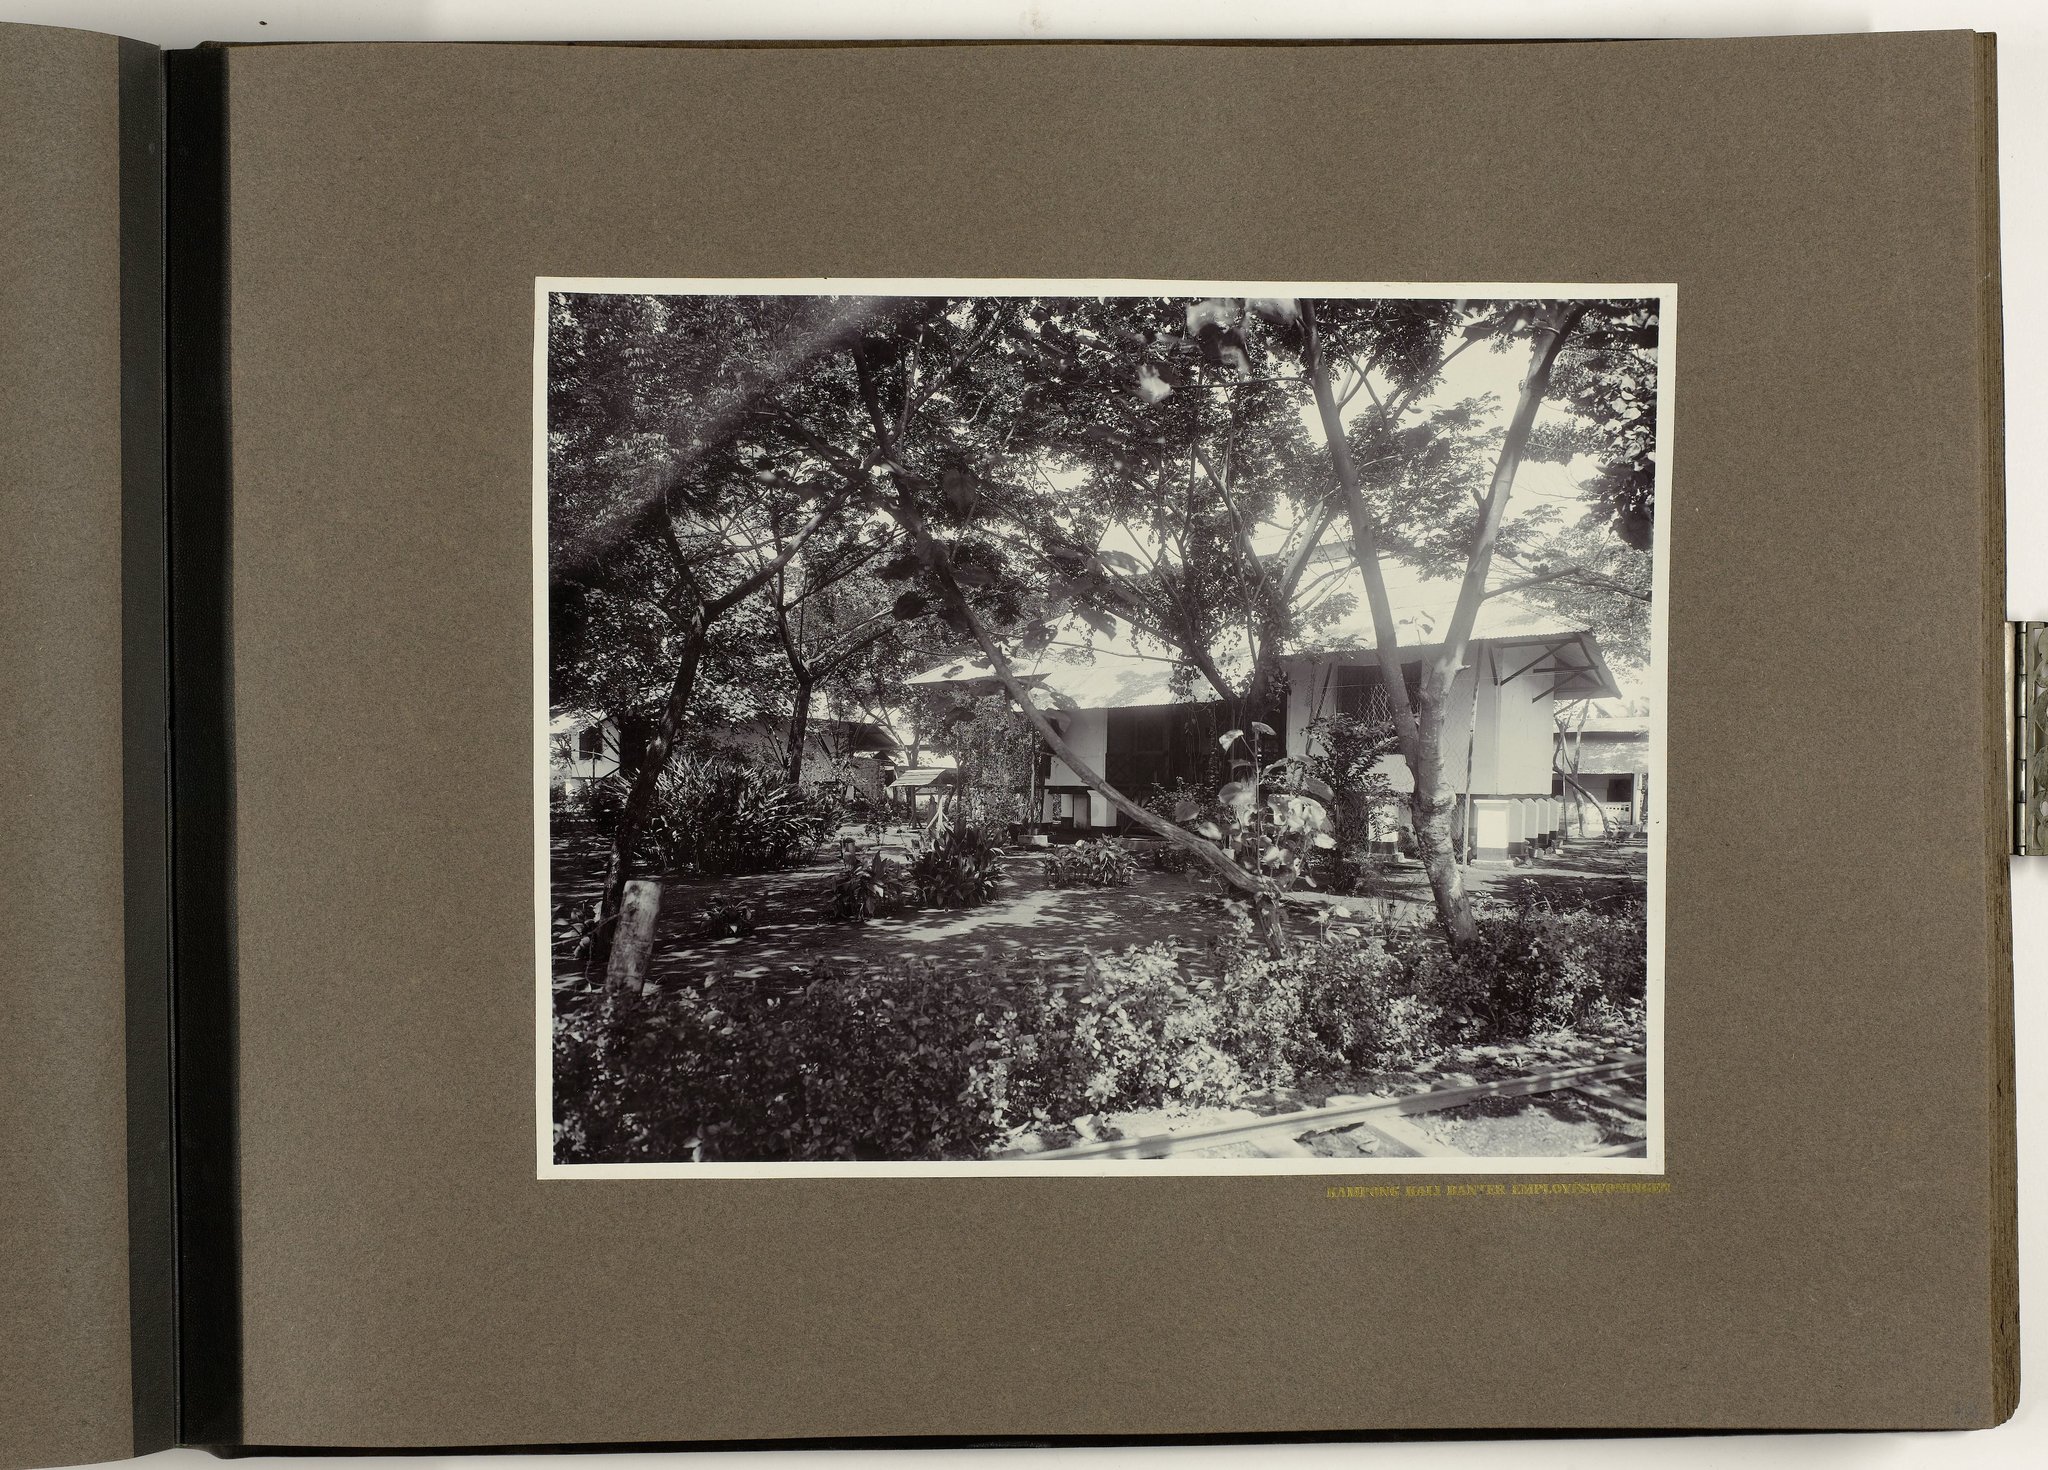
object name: photograph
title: Kampong Kali Banter employéswoningen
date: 1917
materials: photographic support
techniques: gelatin silver print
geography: jatiroto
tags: colonial system, (non-fruit) products of plants or trees: sugarcane, rural housing, e.g. country-house, villa, cottage, public road in village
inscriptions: inscription: ‘KAMPONG KALI BANTER EMPLOYÉSWONINGEN’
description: Werknemerswoningen in het dorp Kali Banter. Witte huizen op palen onder bomen, op de voorgrond rails. Onderdeel van het fotoalbum aangeboden aan F.J. Wirix door het personeel van de Suikeronderneming Djatiroto in 1917.